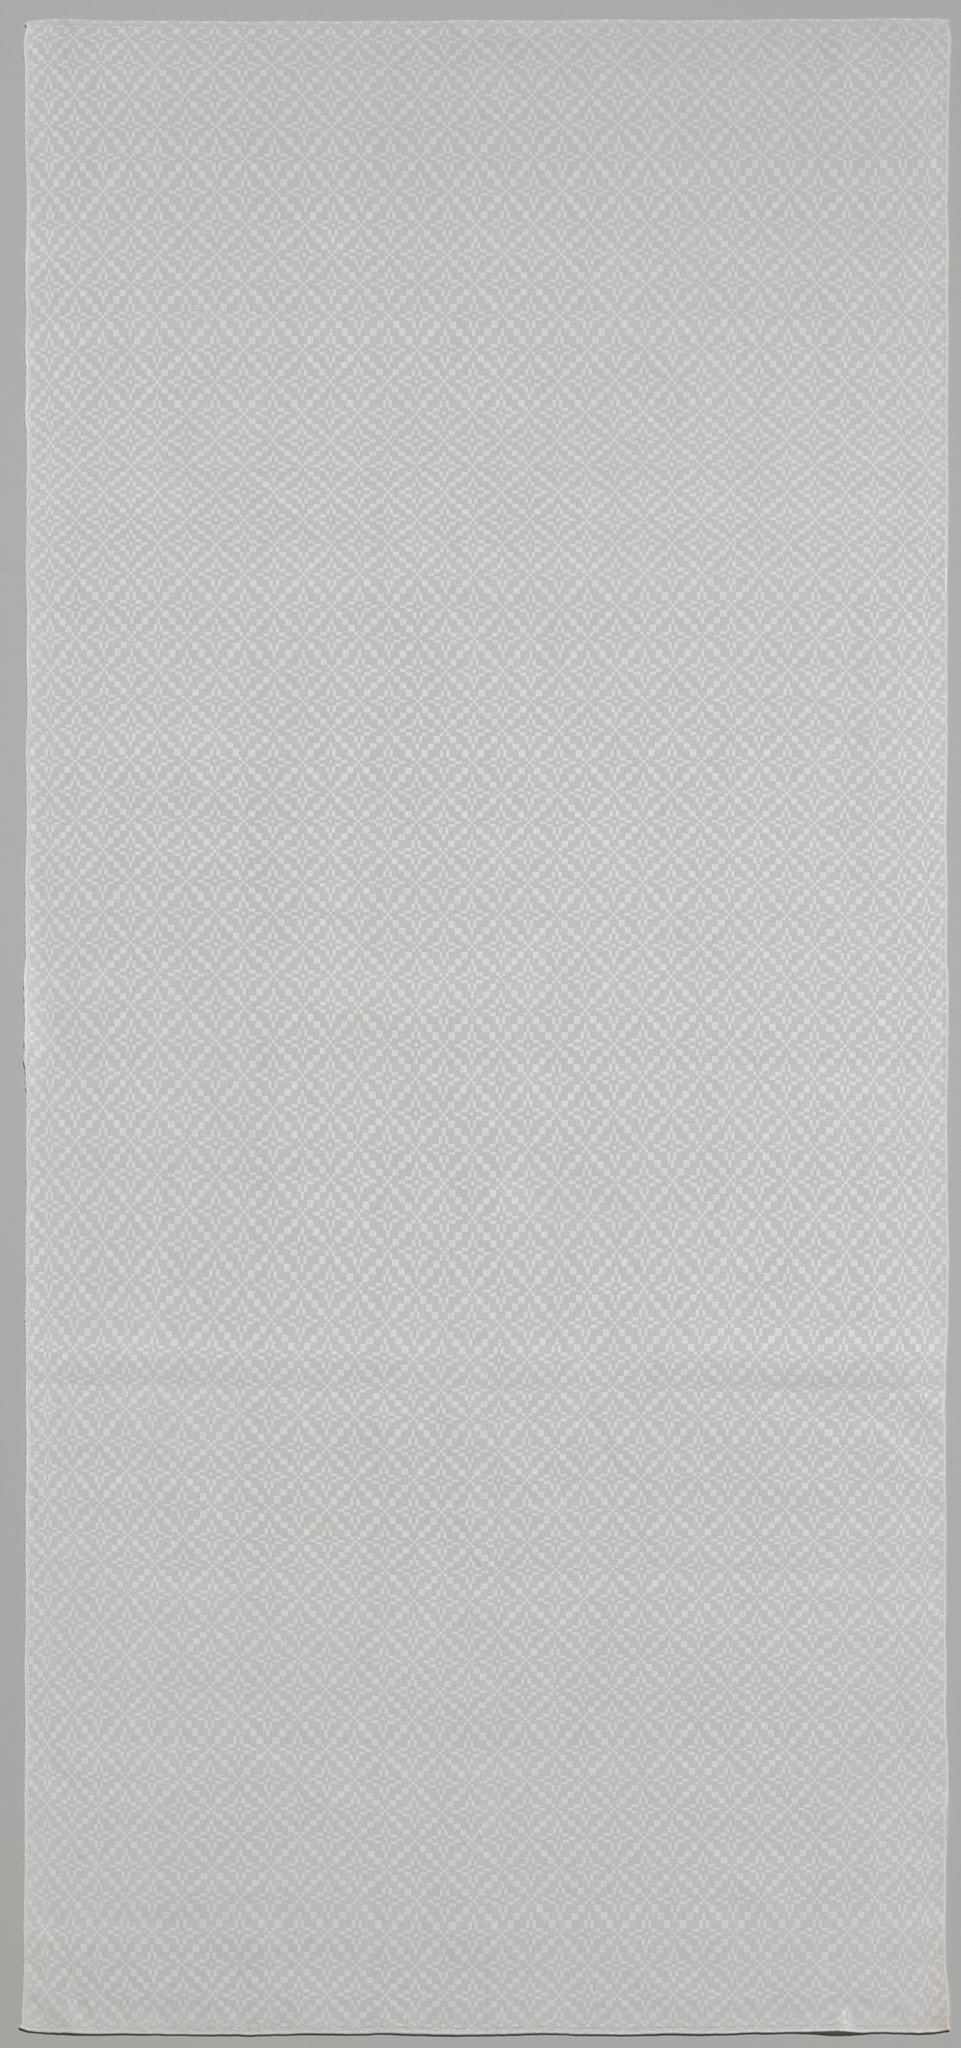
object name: handdwaal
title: Handdwaal van pellendamast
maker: Anonymous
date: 1600-1650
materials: linen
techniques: damask, embroidery, weave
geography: northern netherlands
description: Handdwaal van pellendamast, klein repeterend ruitmotief. Boven en onderaan randje van drie opengewerkte lijnen.